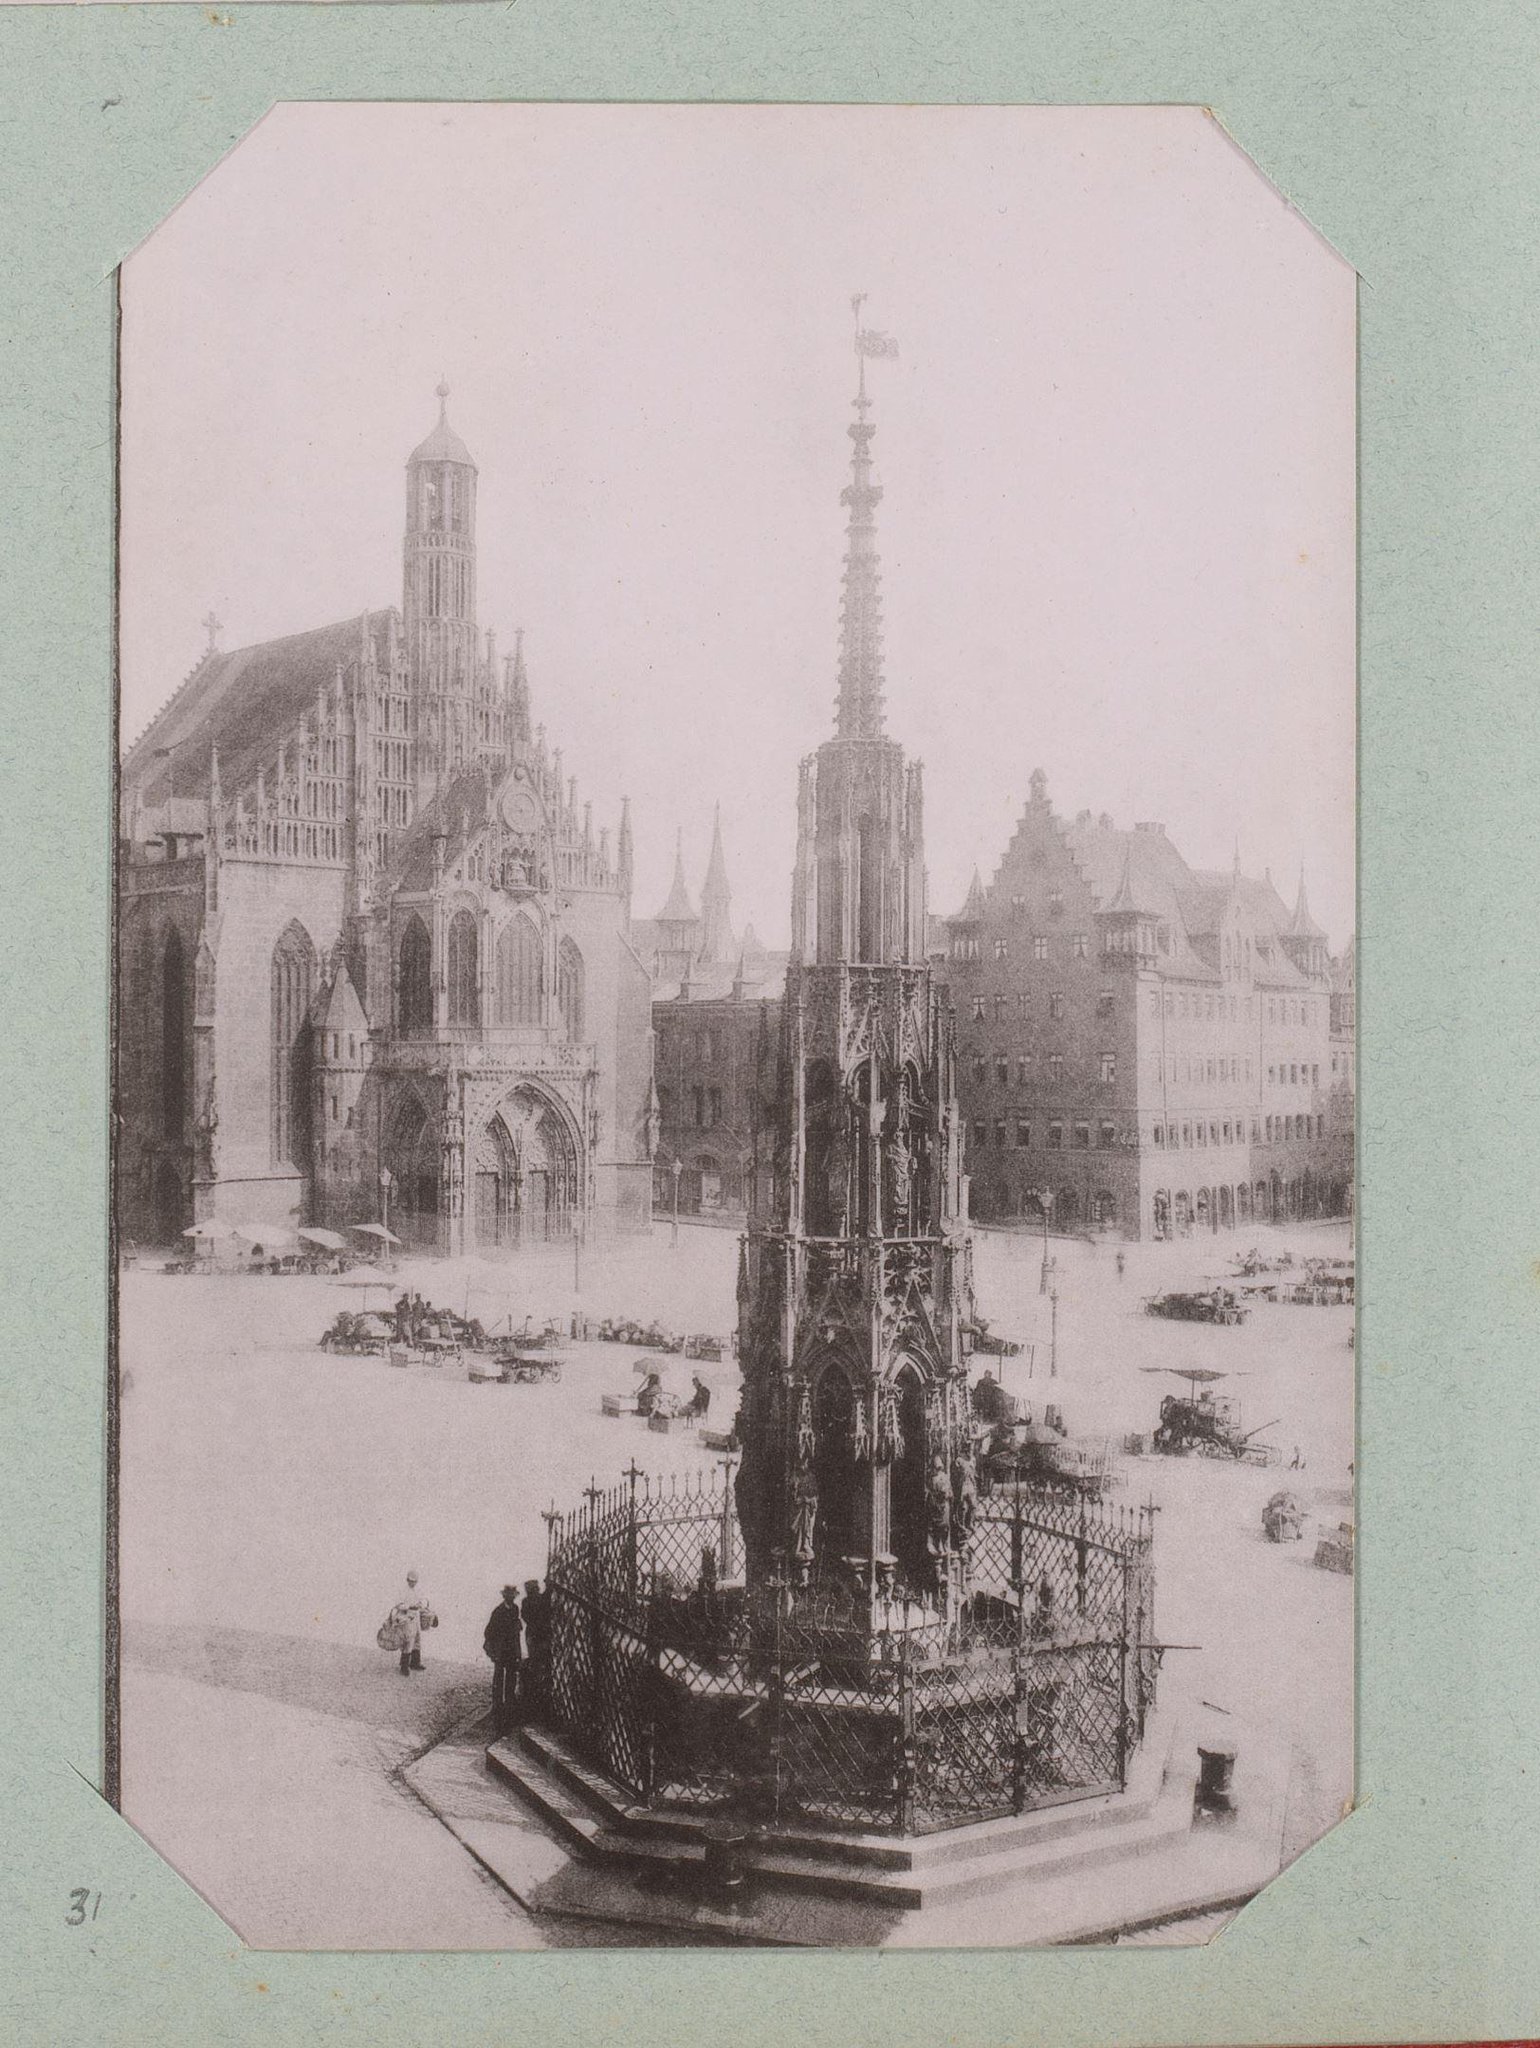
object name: album leaf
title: Schöner Brunnen op de Hauptmarkt, Neurenberg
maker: Anonymous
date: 1890-1900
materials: paper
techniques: photograph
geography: nuremberg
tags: square, place, circus, etc., ornamental fountain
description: Deze prent maakt deel uit van een album.